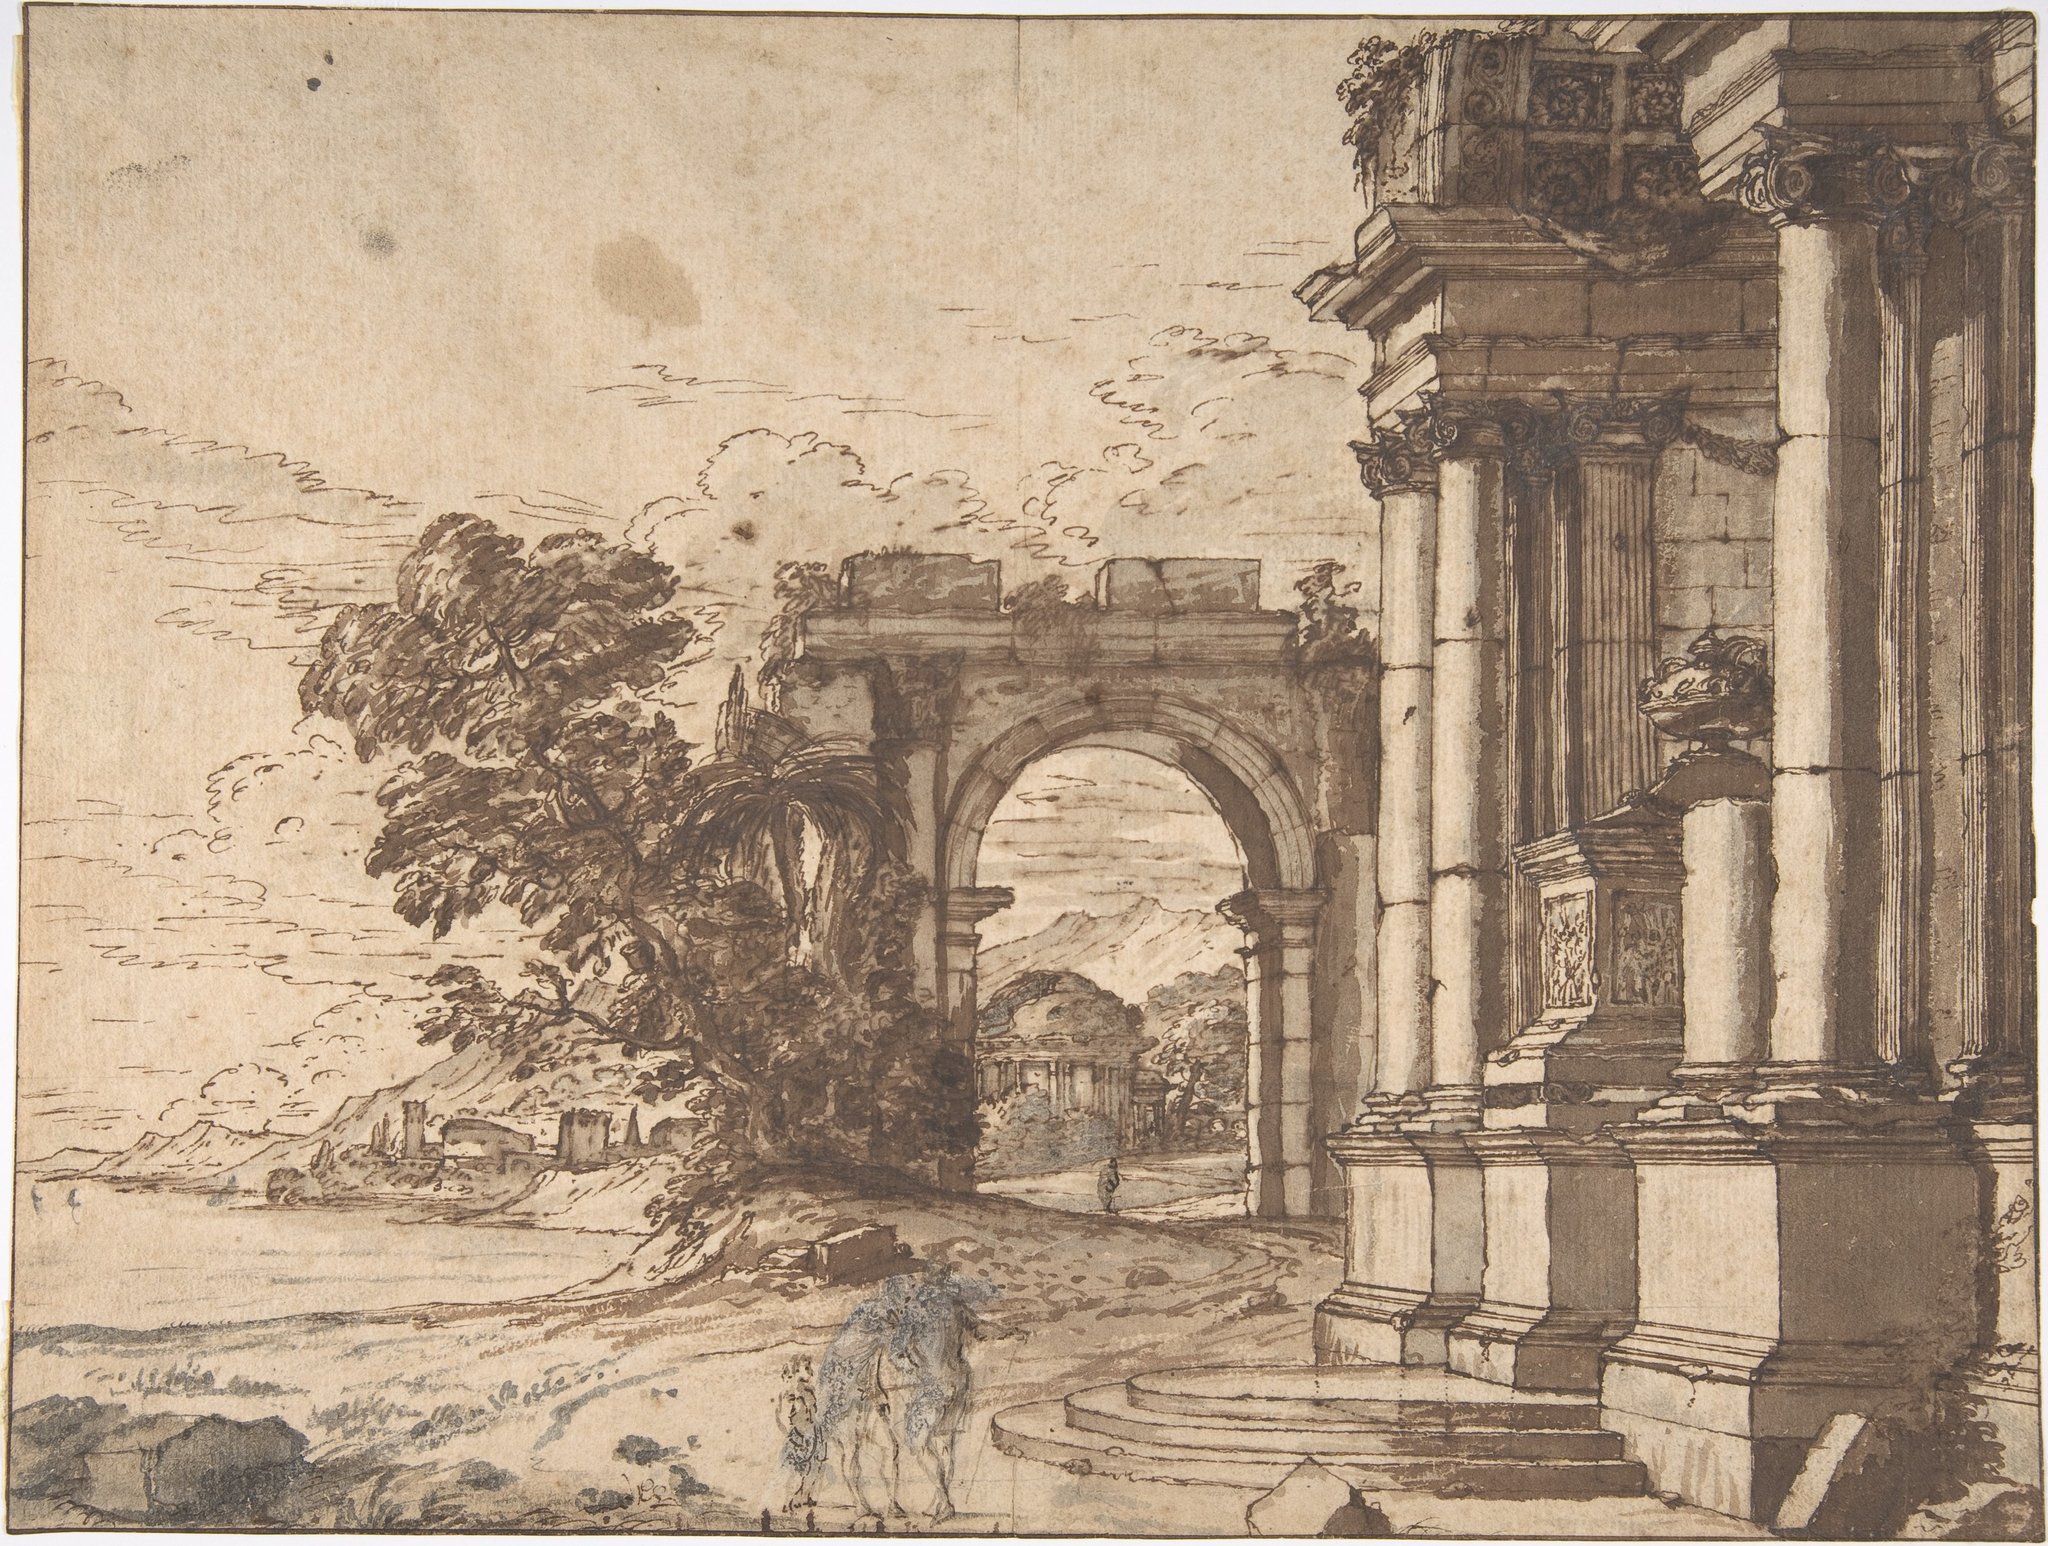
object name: drawing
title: Landscape with Classical Architecture by a Lake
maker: anonymous, french, 17th century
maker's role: artist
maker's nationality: french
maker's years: 1600-1700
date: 1601-1700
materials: gouache, graphite, ink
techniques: brush, heightening, pen, wash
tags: arches,columns,lakes,landscapes